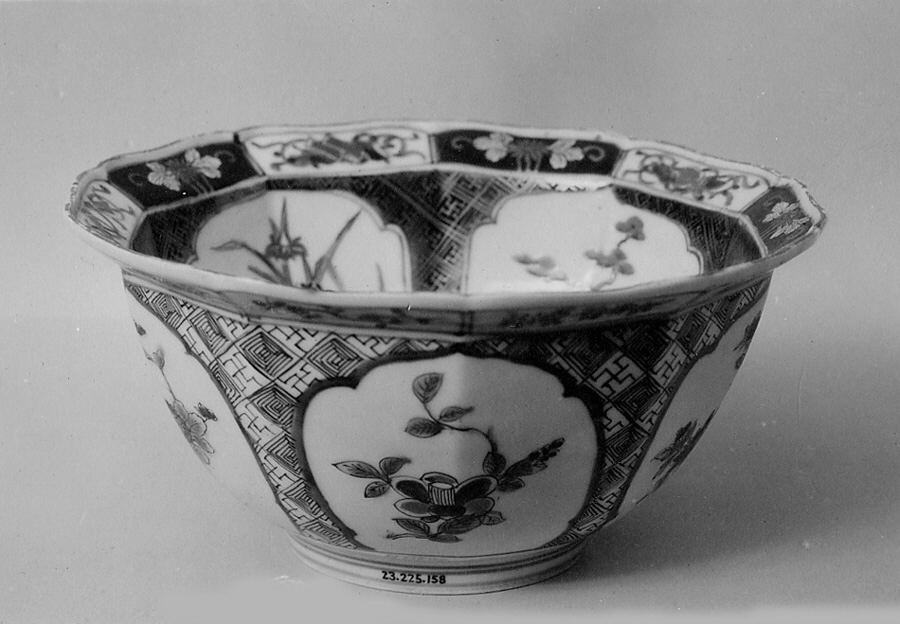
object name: bowl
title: Ten-Sided Bowl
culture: japanese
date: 1780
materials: enamel, porcelain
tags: flowers,leaves